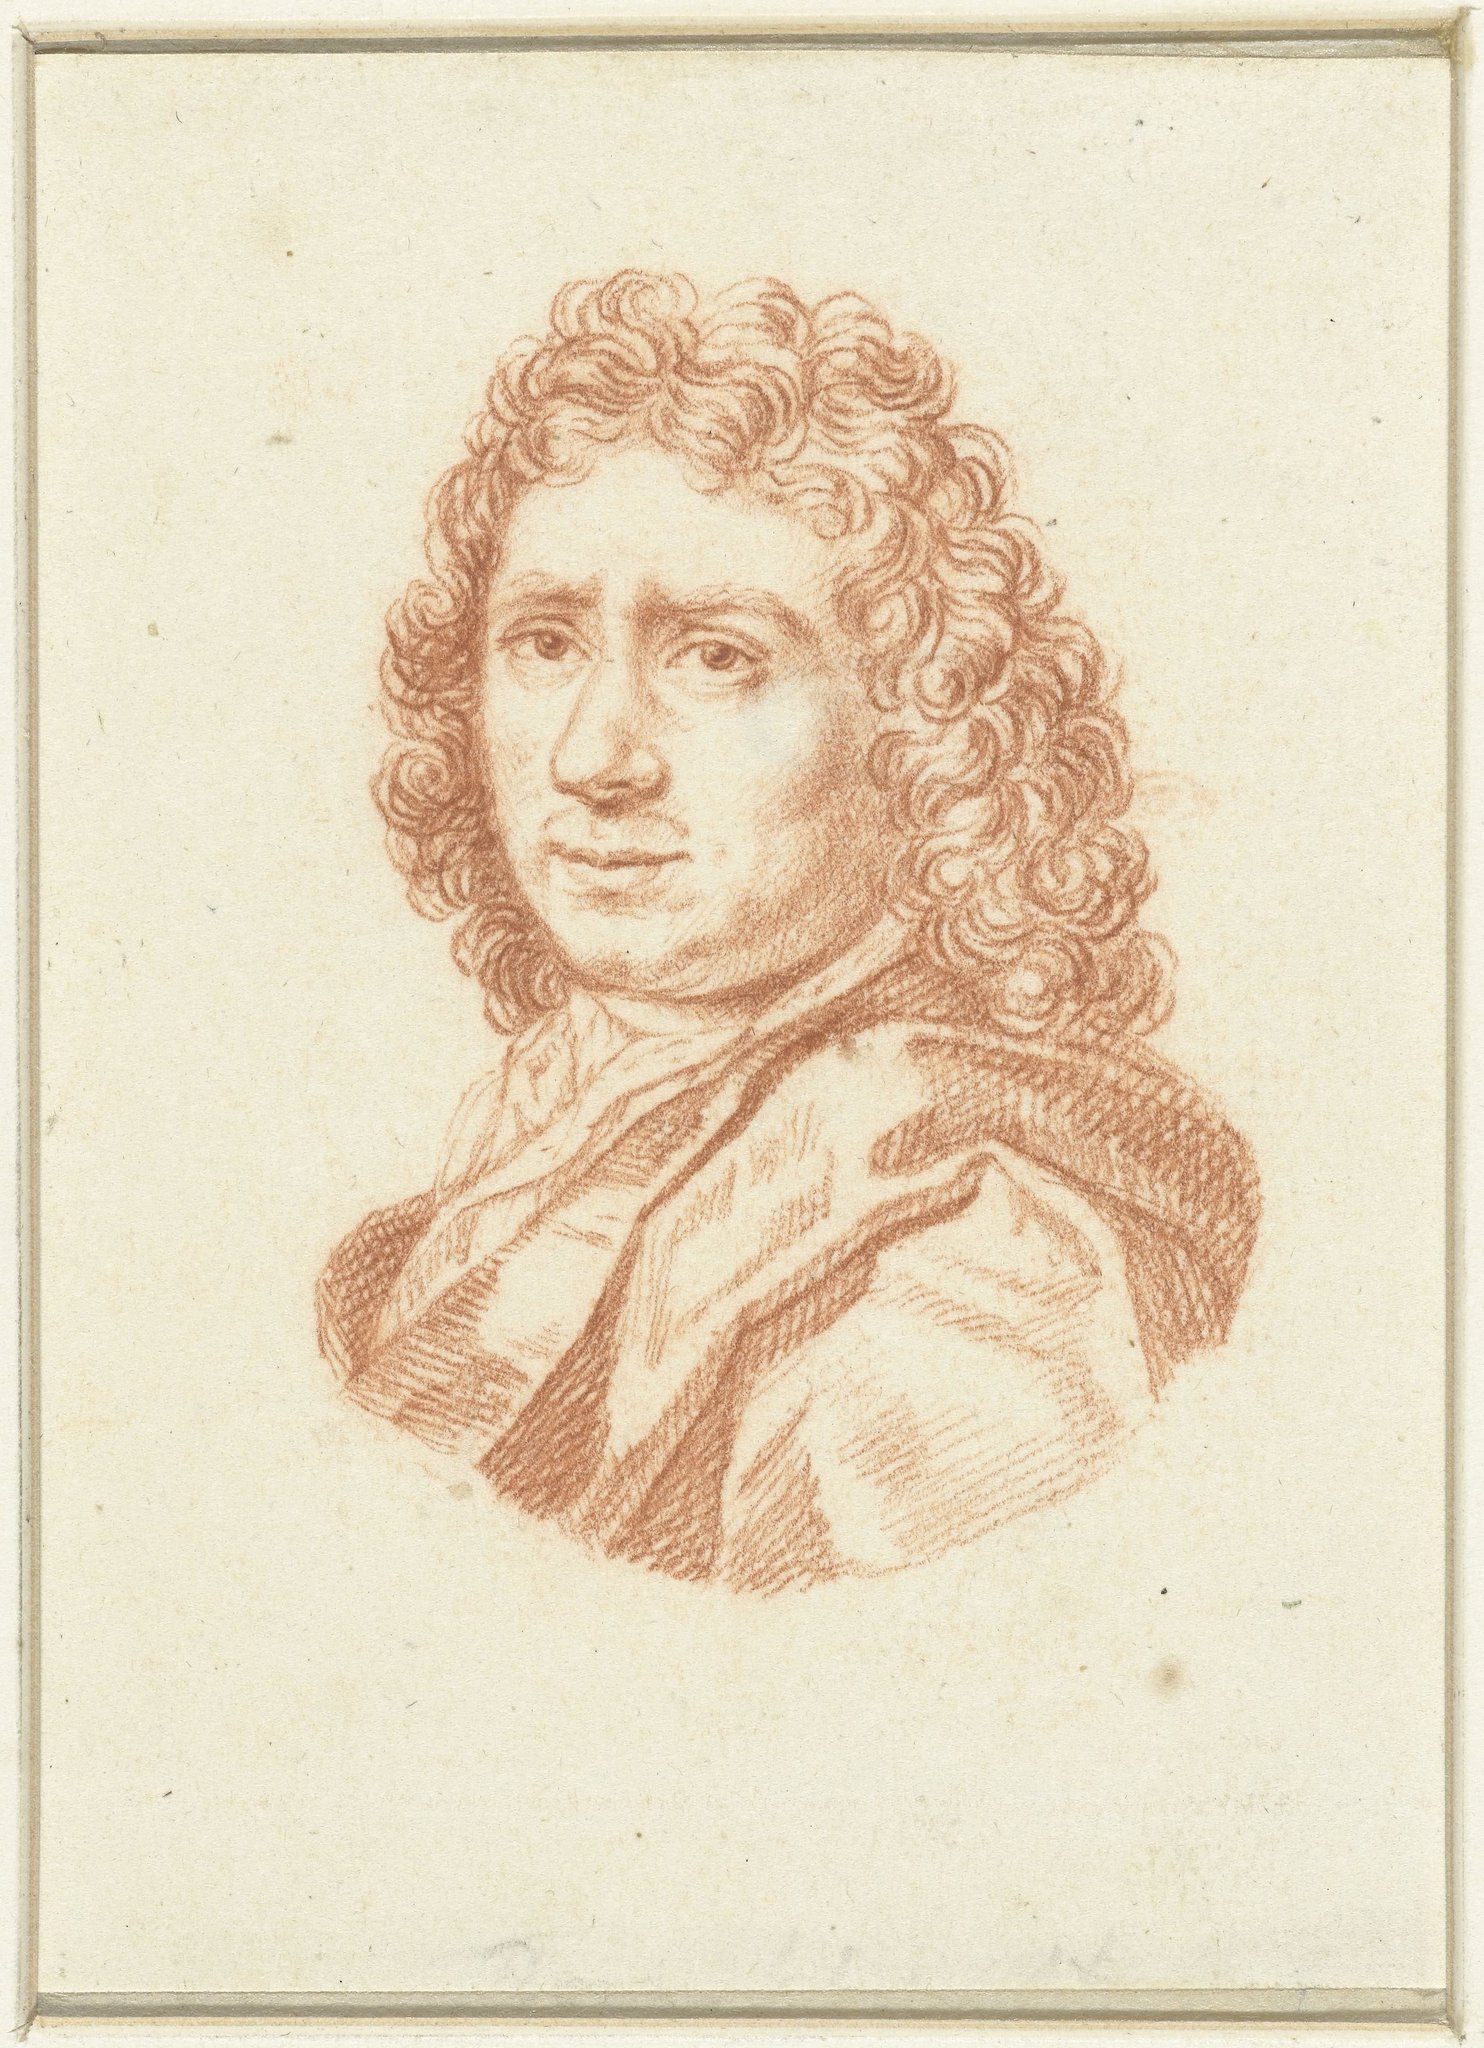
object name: design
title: Portret van een onbekende kunstenaar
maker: jacob houbraken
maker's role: draughtsman, print maker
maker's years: 1698-1780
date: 1708-1780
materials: chalk, paper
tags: anonymous historical person portrayed alone, portrait, self-portrait of artist